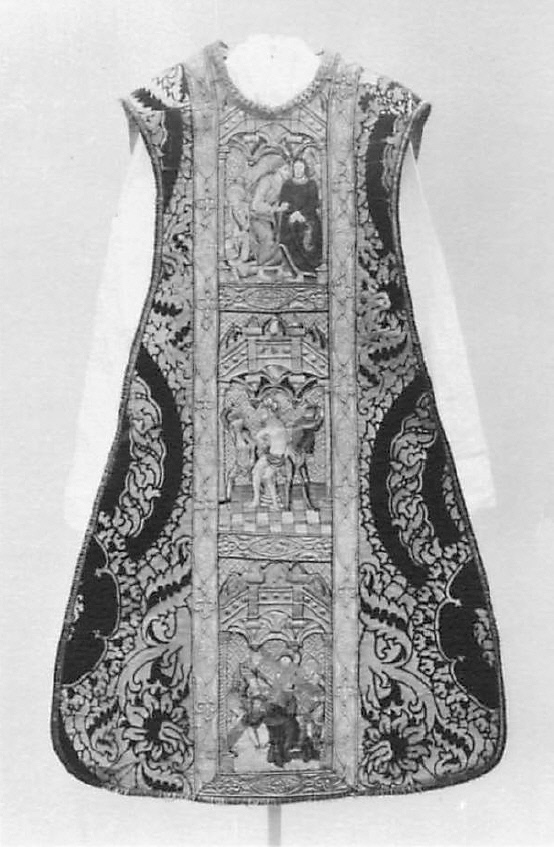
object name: chasuble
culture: italian or spanish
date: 1467-1500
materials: metal thread, silk